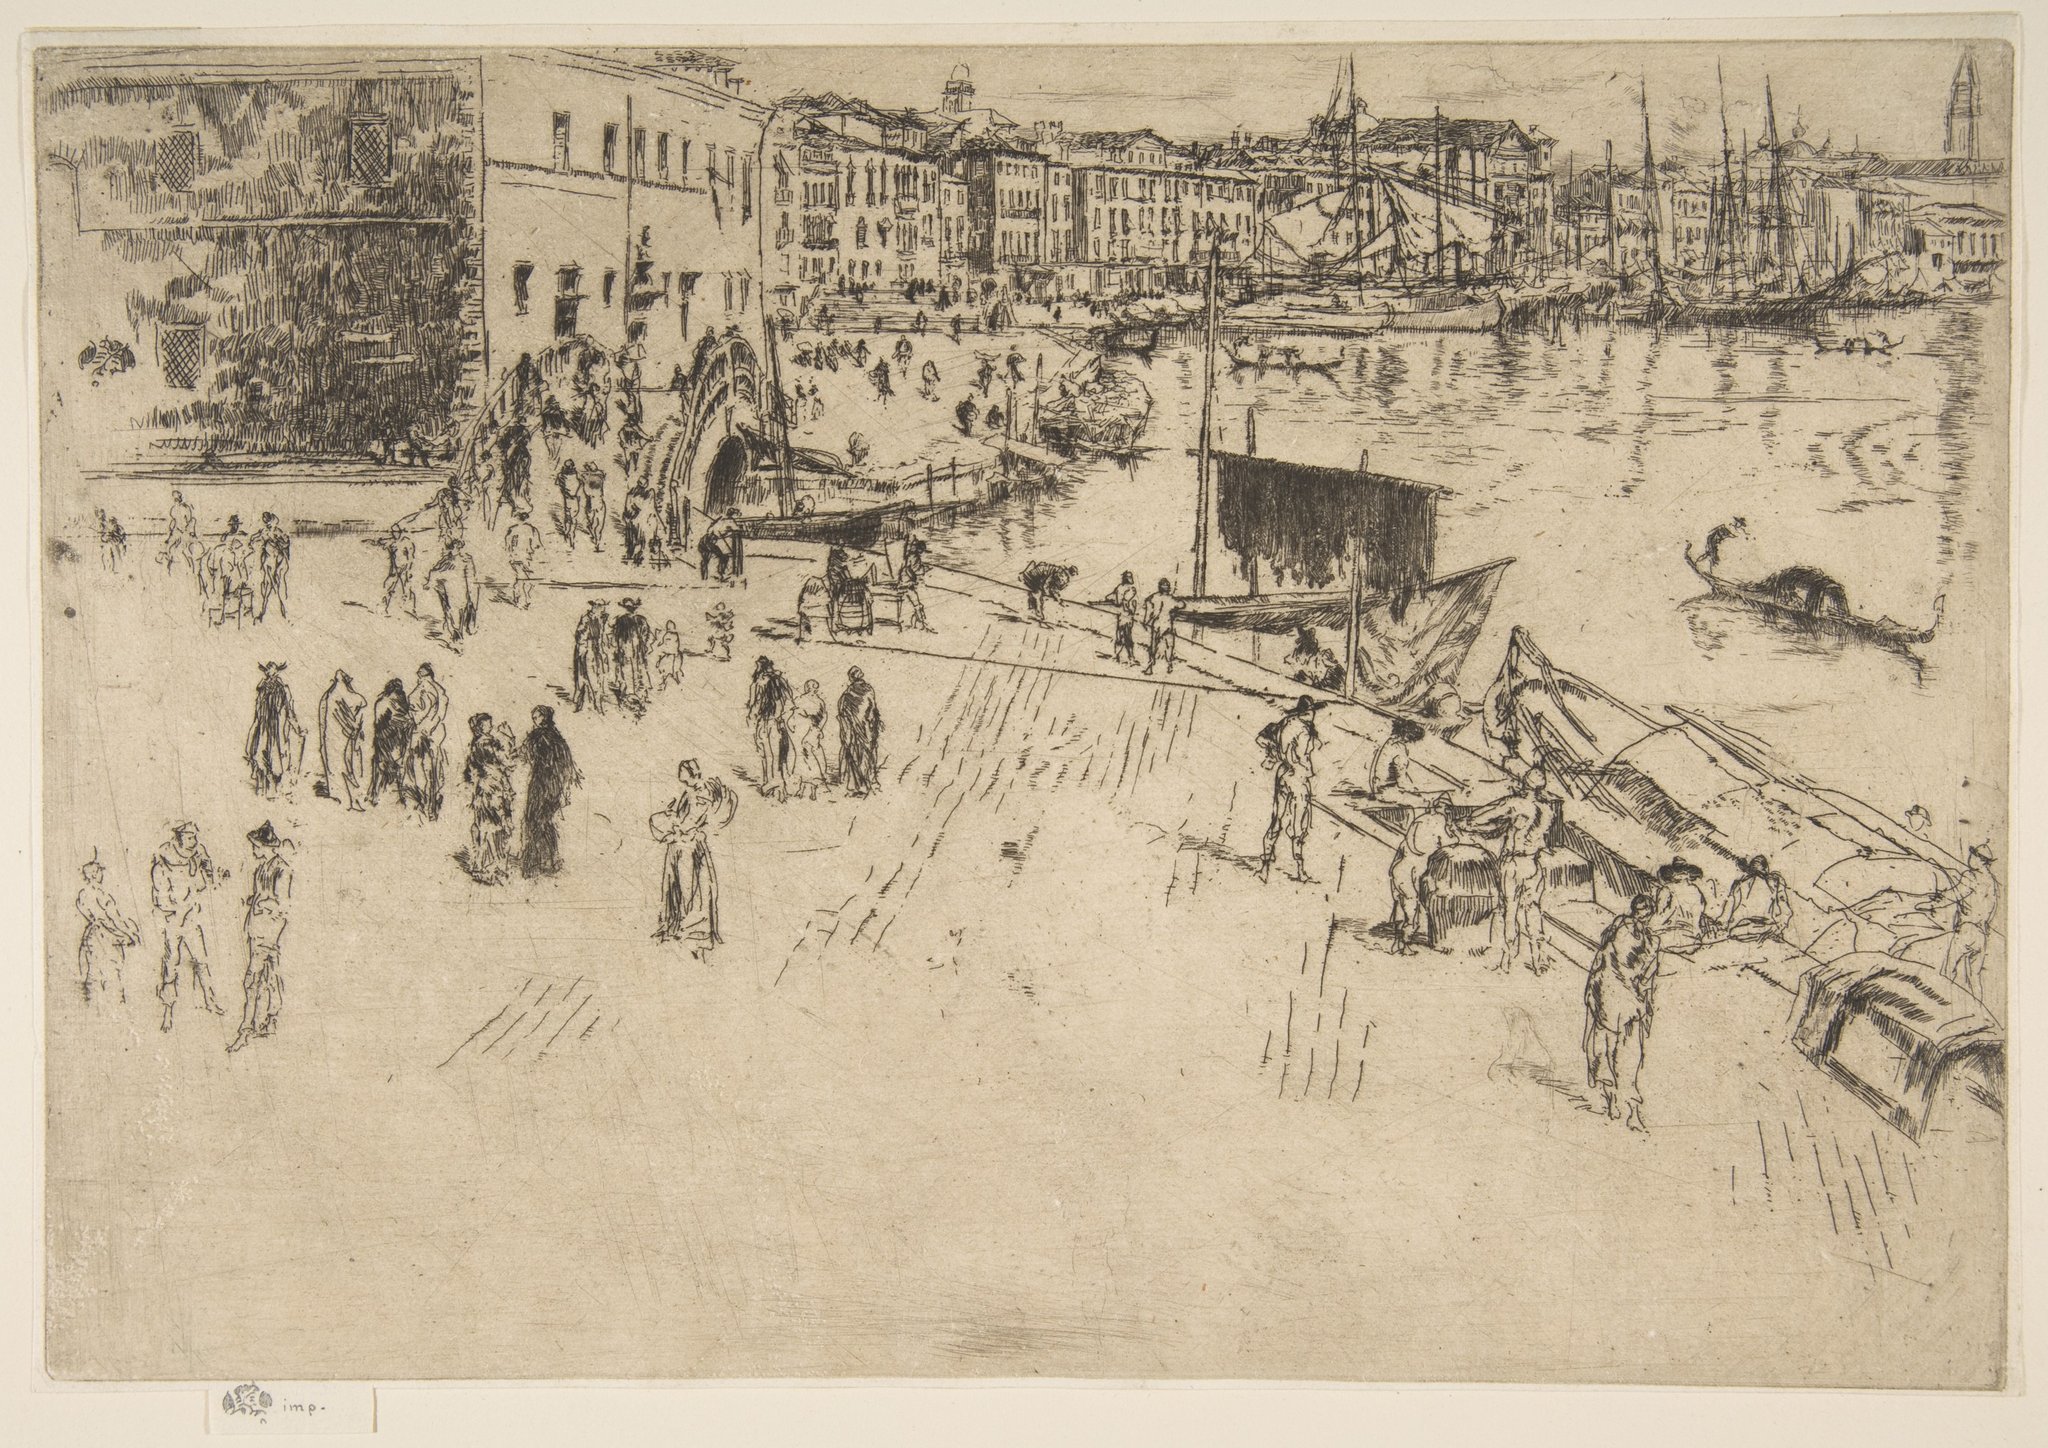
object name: print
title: The Riva, No. 1 (The Riva)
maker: james mcneill whistler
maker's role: artist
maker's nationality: american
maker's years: 1834-1903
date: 1879-1880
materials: ink, paper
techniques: drypoint, etching, printing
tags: buildings,rivers,boats,venice